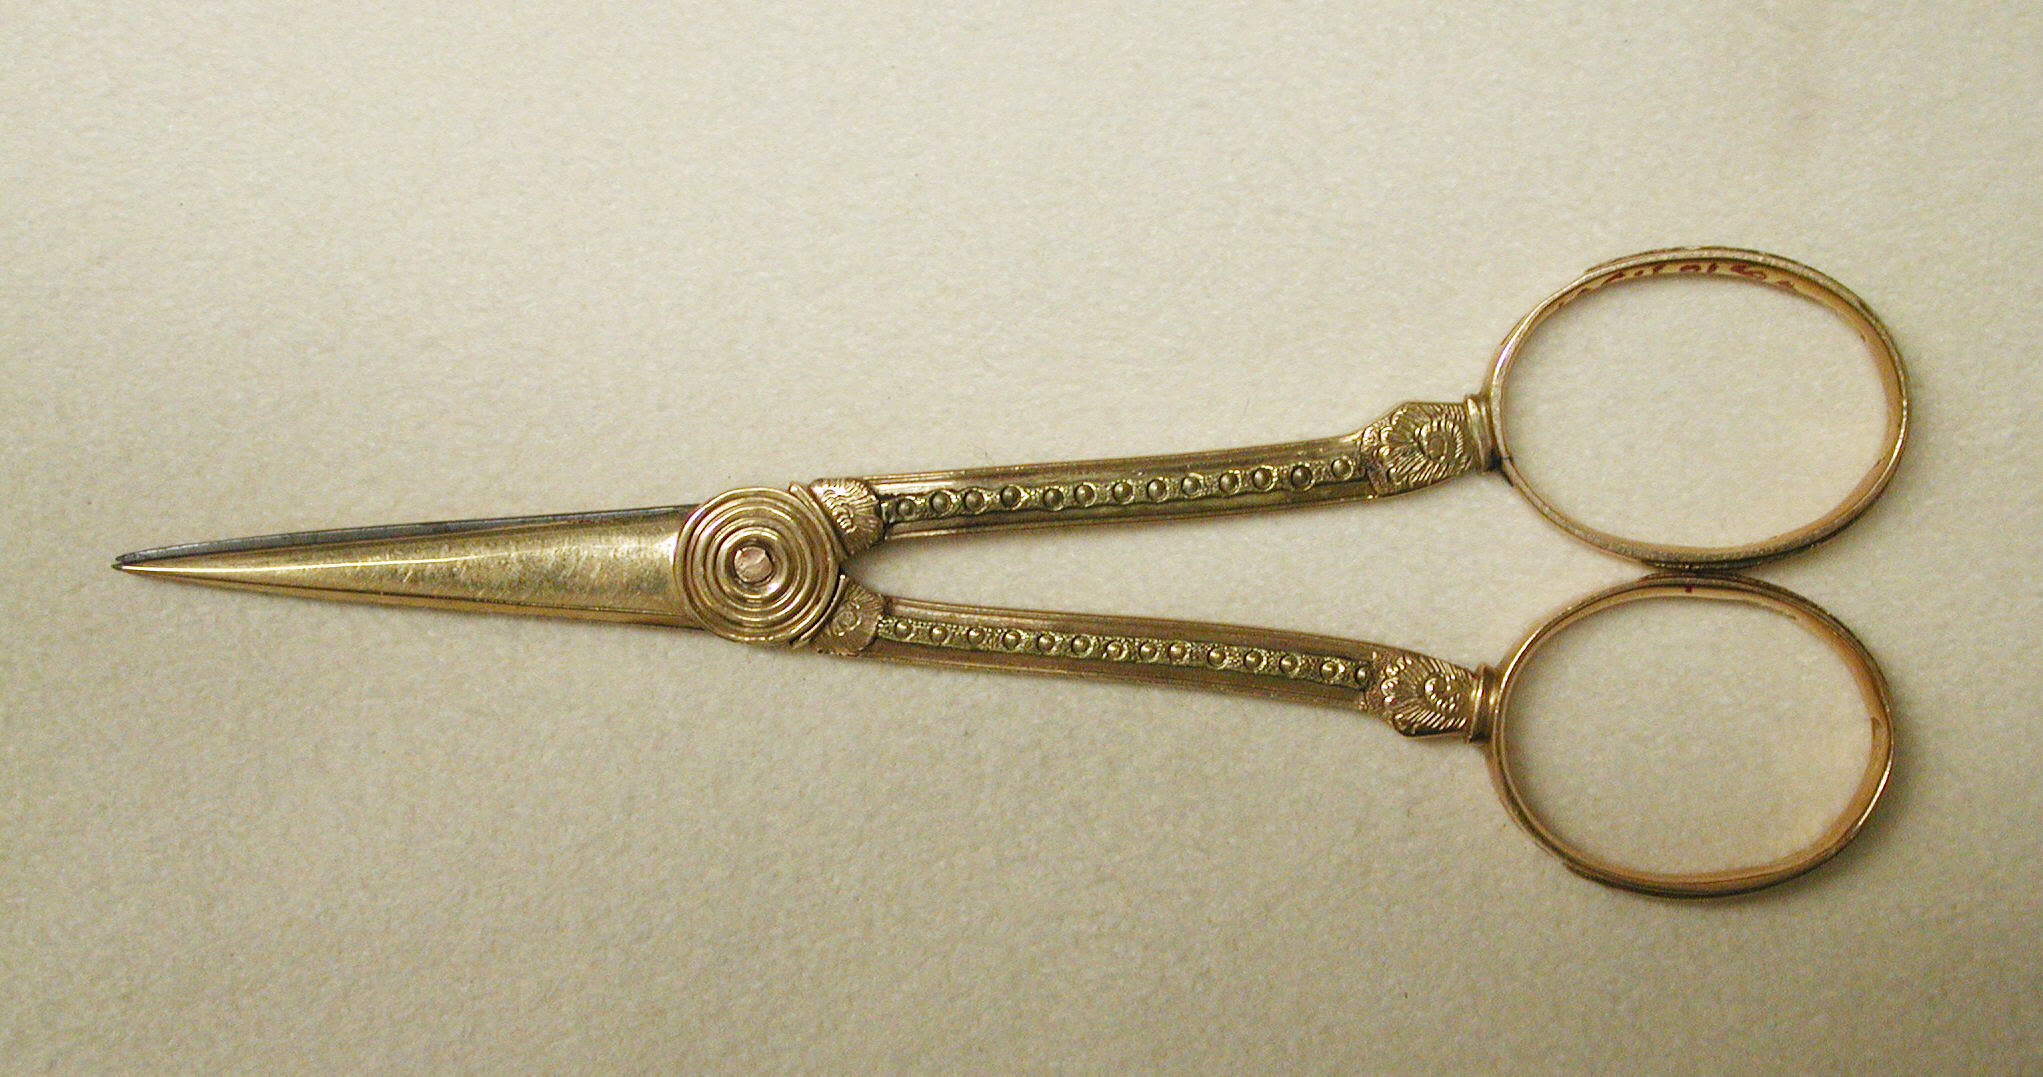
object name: scissors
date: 1775-1781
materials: gold, steel